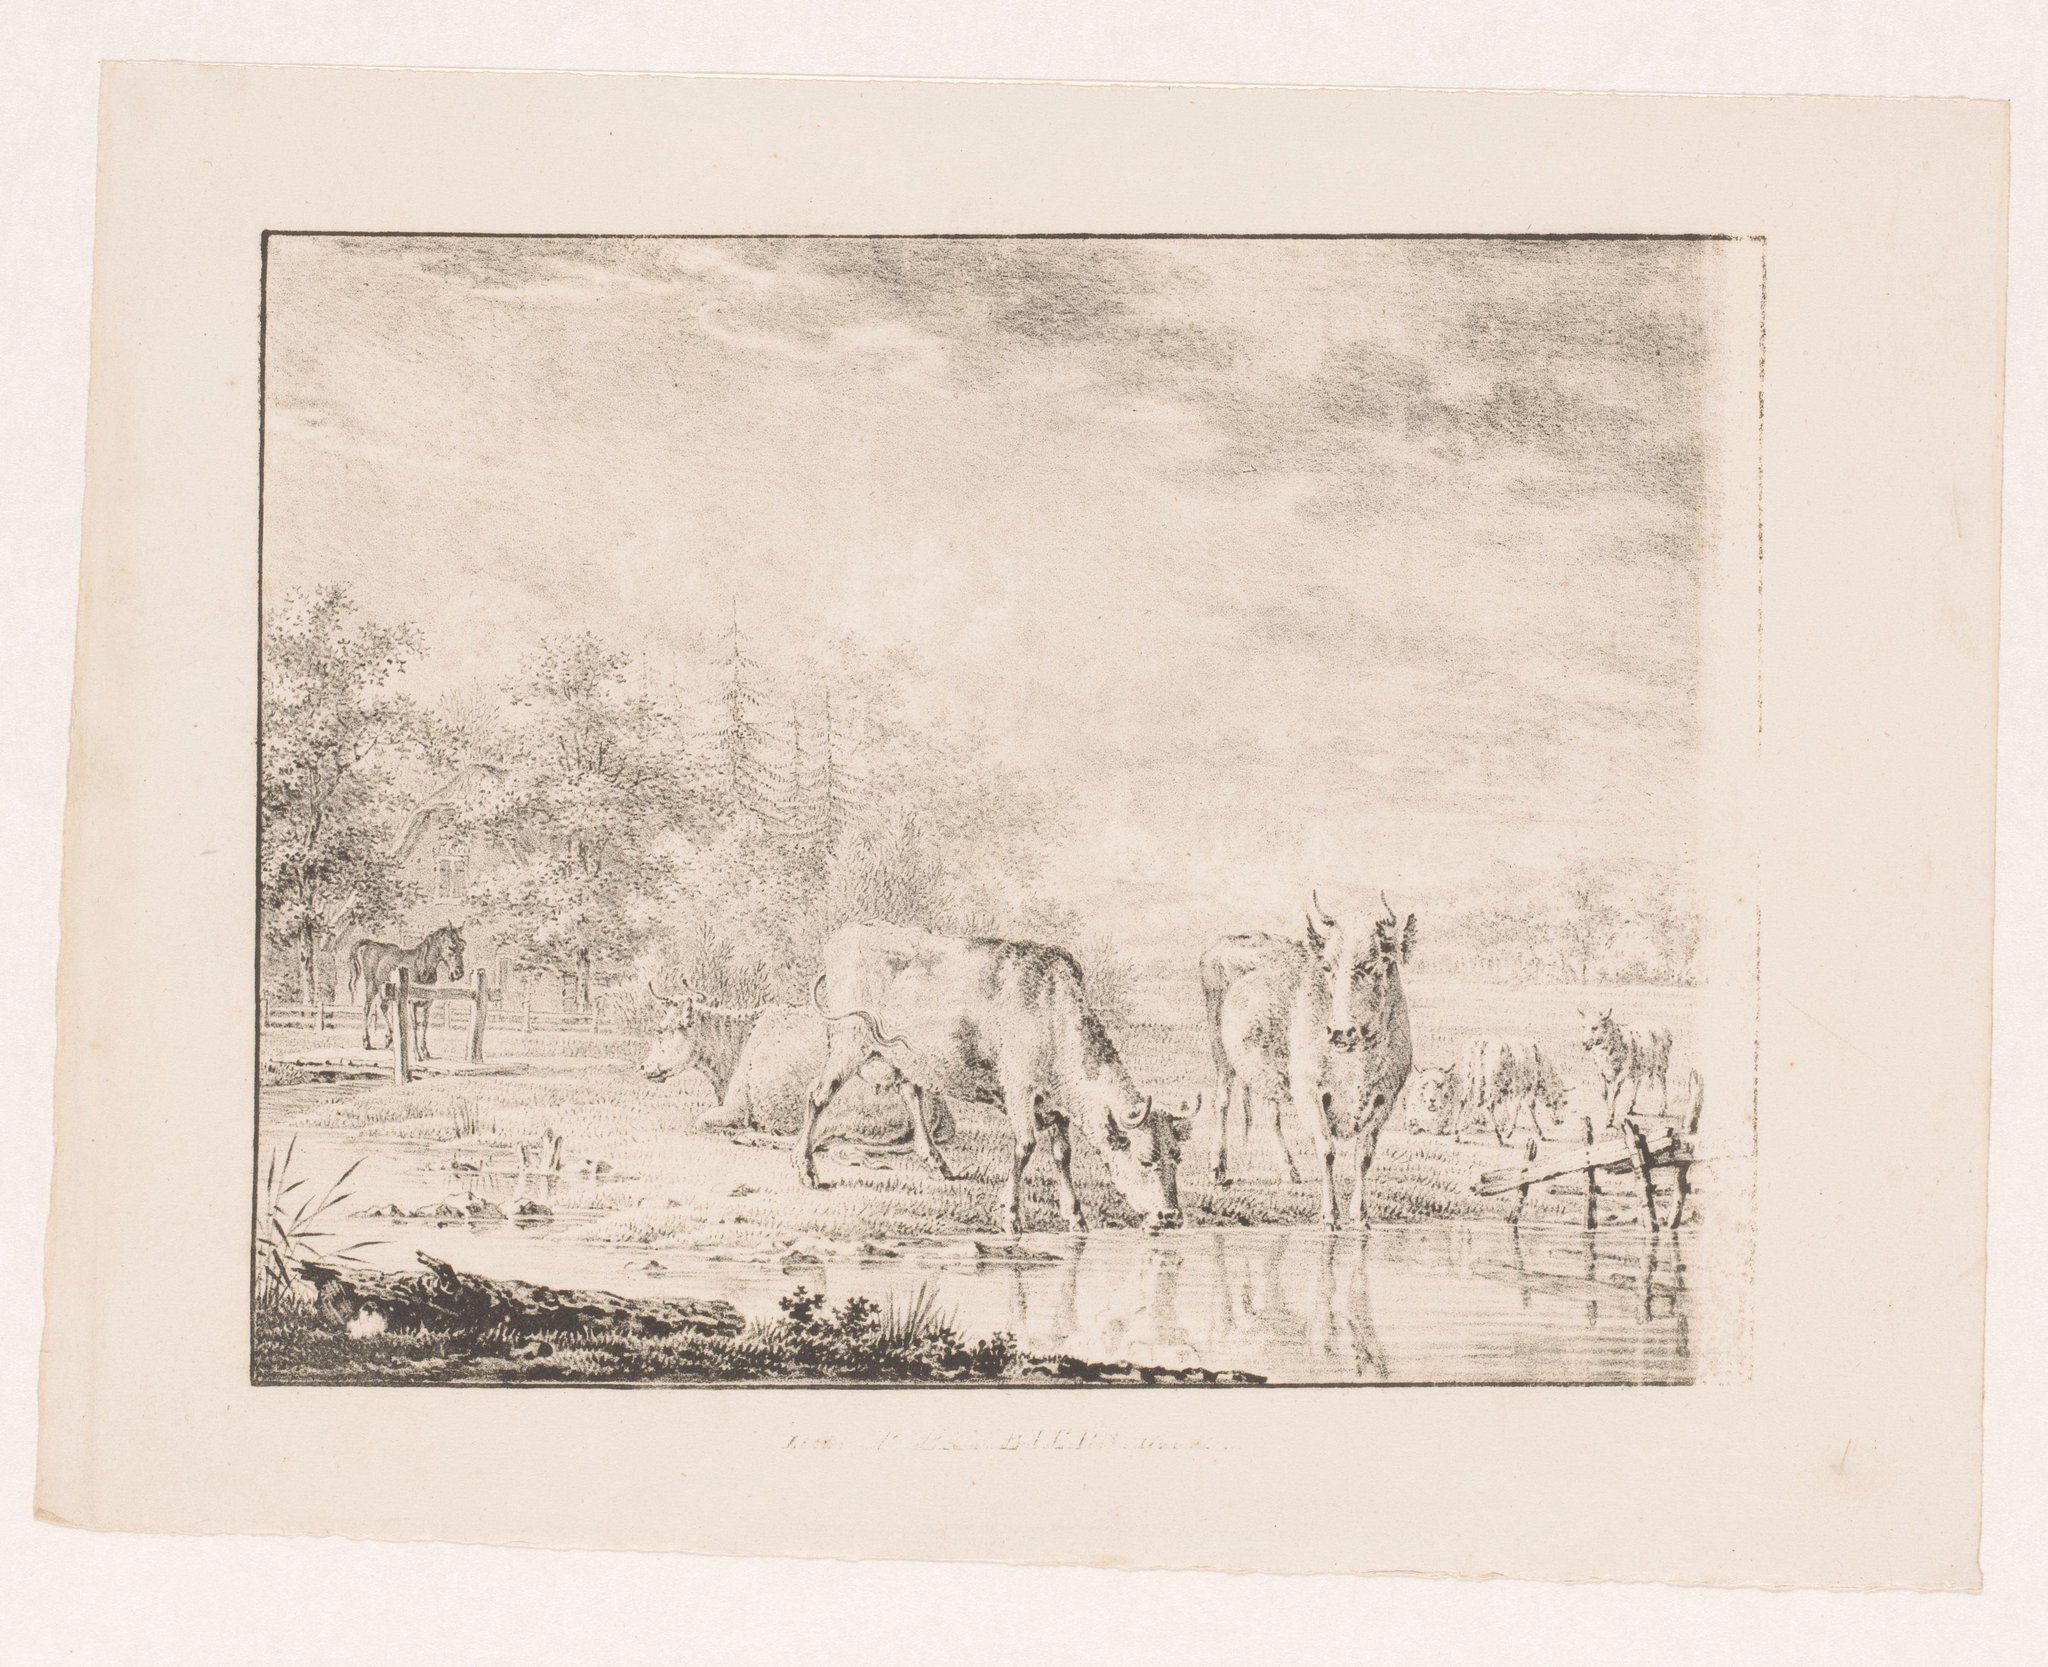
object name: print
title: Koeien bij het water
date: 1809-1837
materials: paper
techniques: lithograph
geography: netherlands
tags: cow, sheep, horse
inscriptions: collector's mark: Lugt 2228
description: Links staat een paard achter een hek. Rechts van de koeien staan drie schapen.